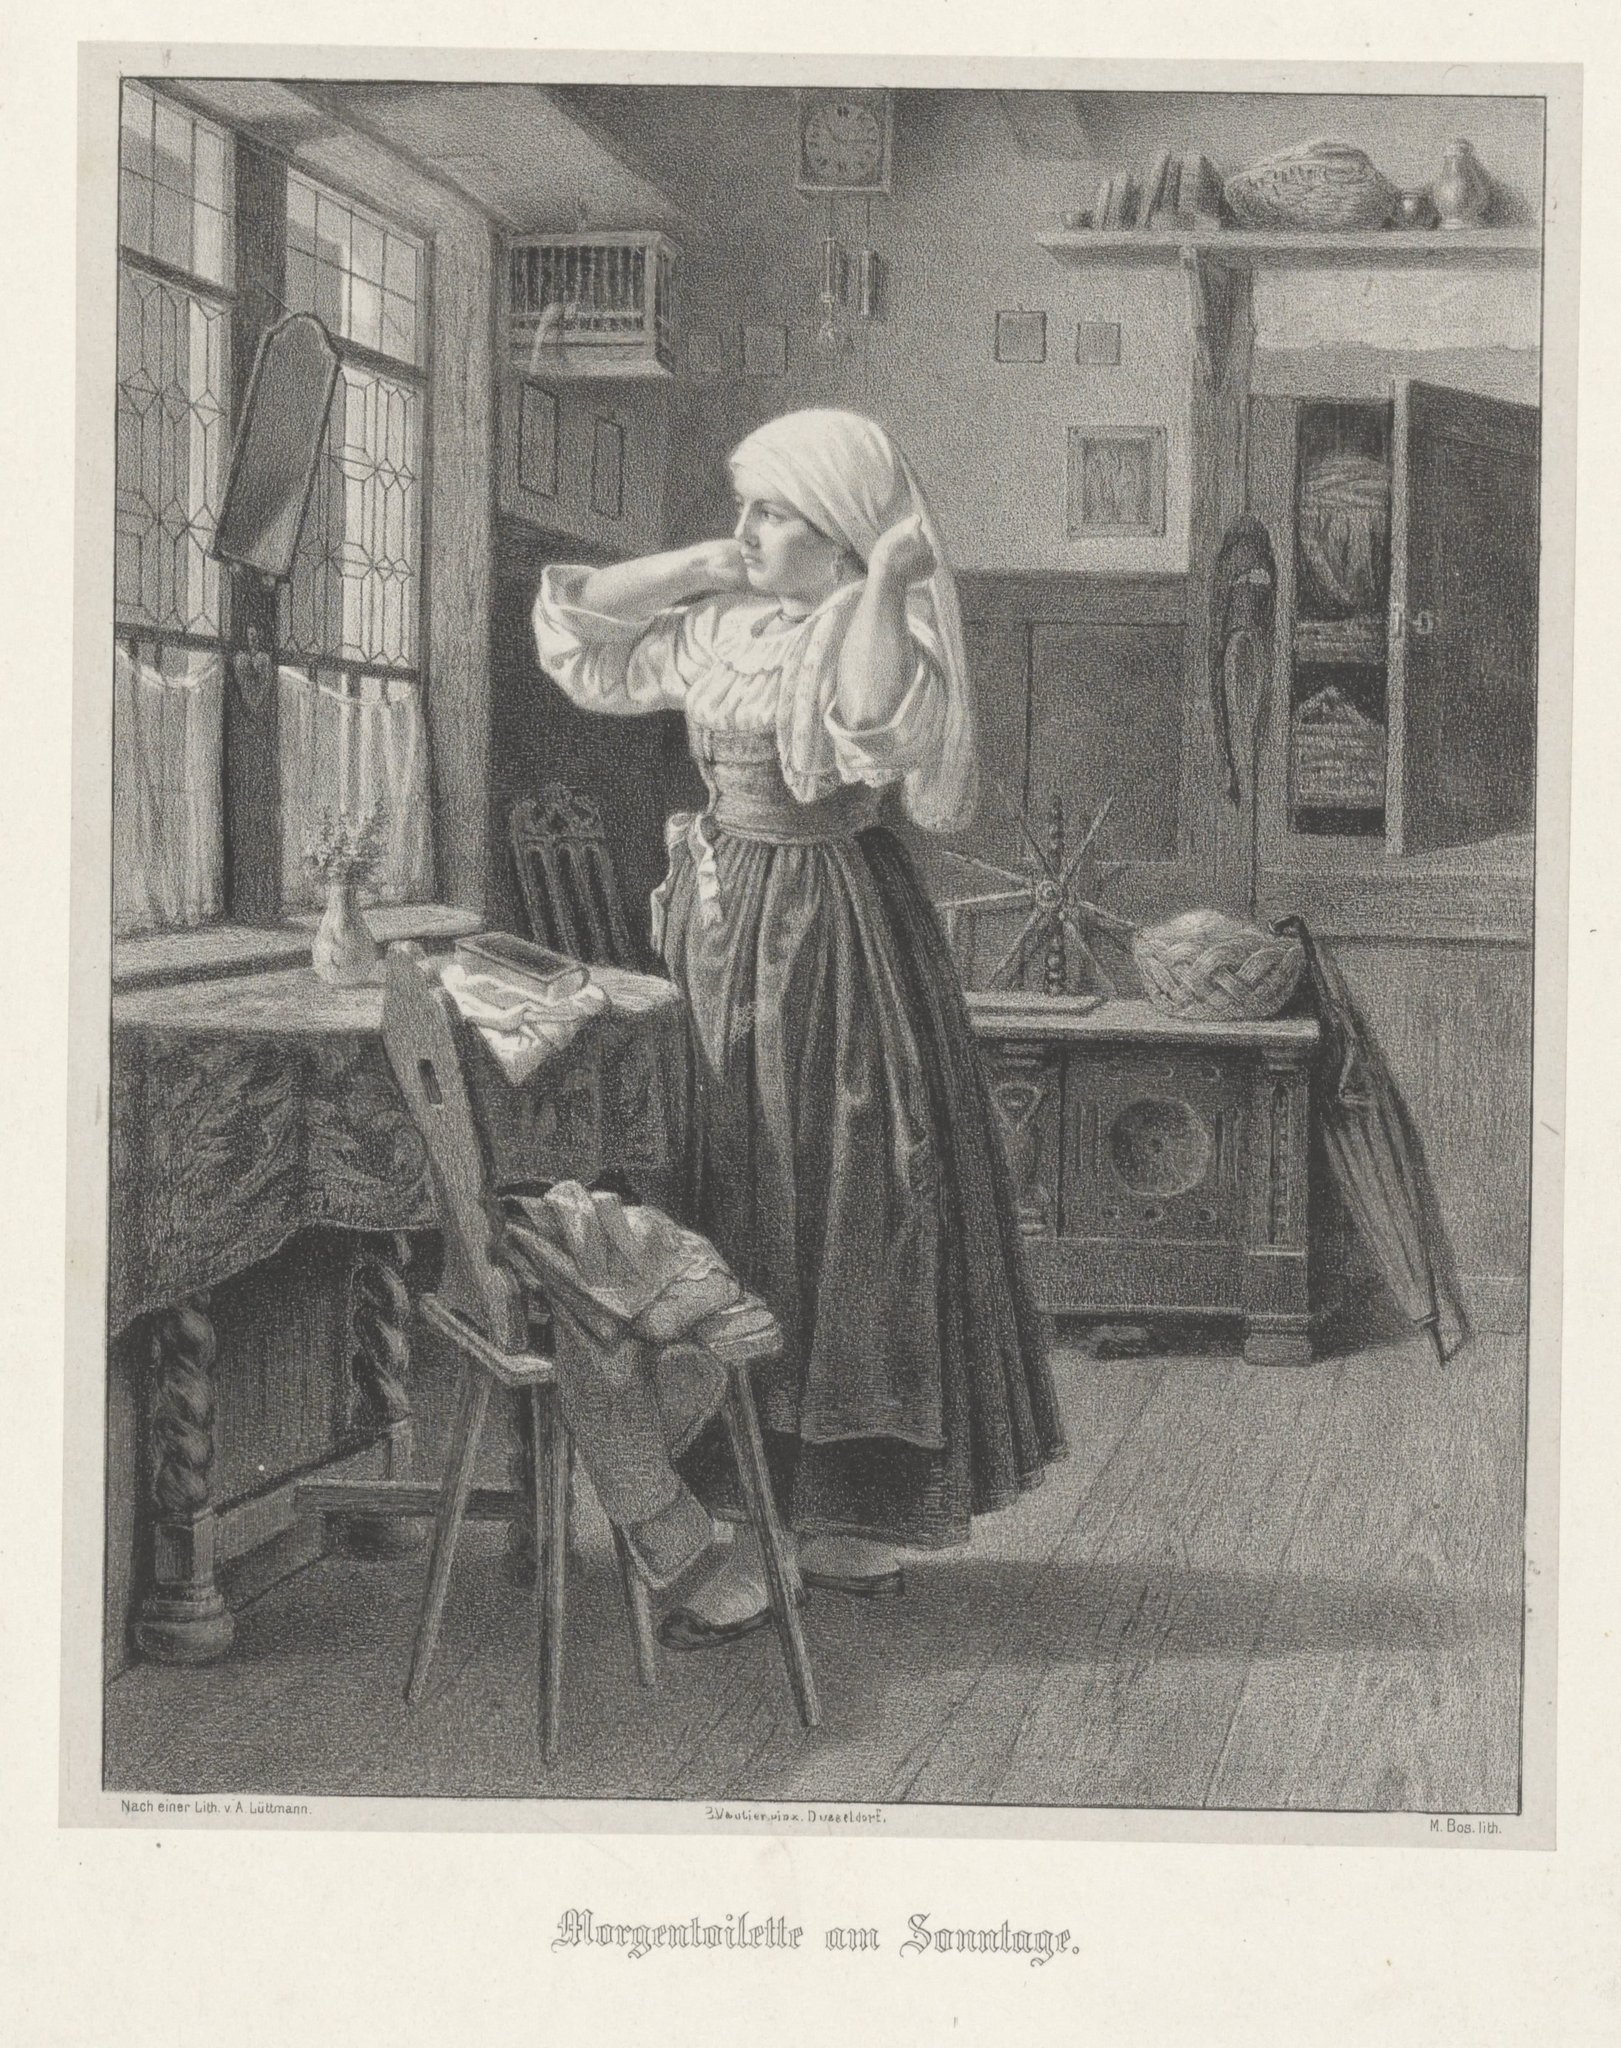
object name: print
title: Morgentoilette am Sonntage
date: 1841-1902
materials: paper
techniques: lithograph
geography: netherlands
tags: looking in the mirror; (possibly: contemplation of own beauty - aa - (for) women), interior of the house, dressing oneself, getting dressed - aa - female human figure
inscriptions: collector's mark: Lugt 2228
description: De vrouw kijkt in de spiegel terwijl zij haar hoofddoek omknoopt. Op de stoel bij de tafel ligt een jas. Achter haar staat de deur van een kast open.